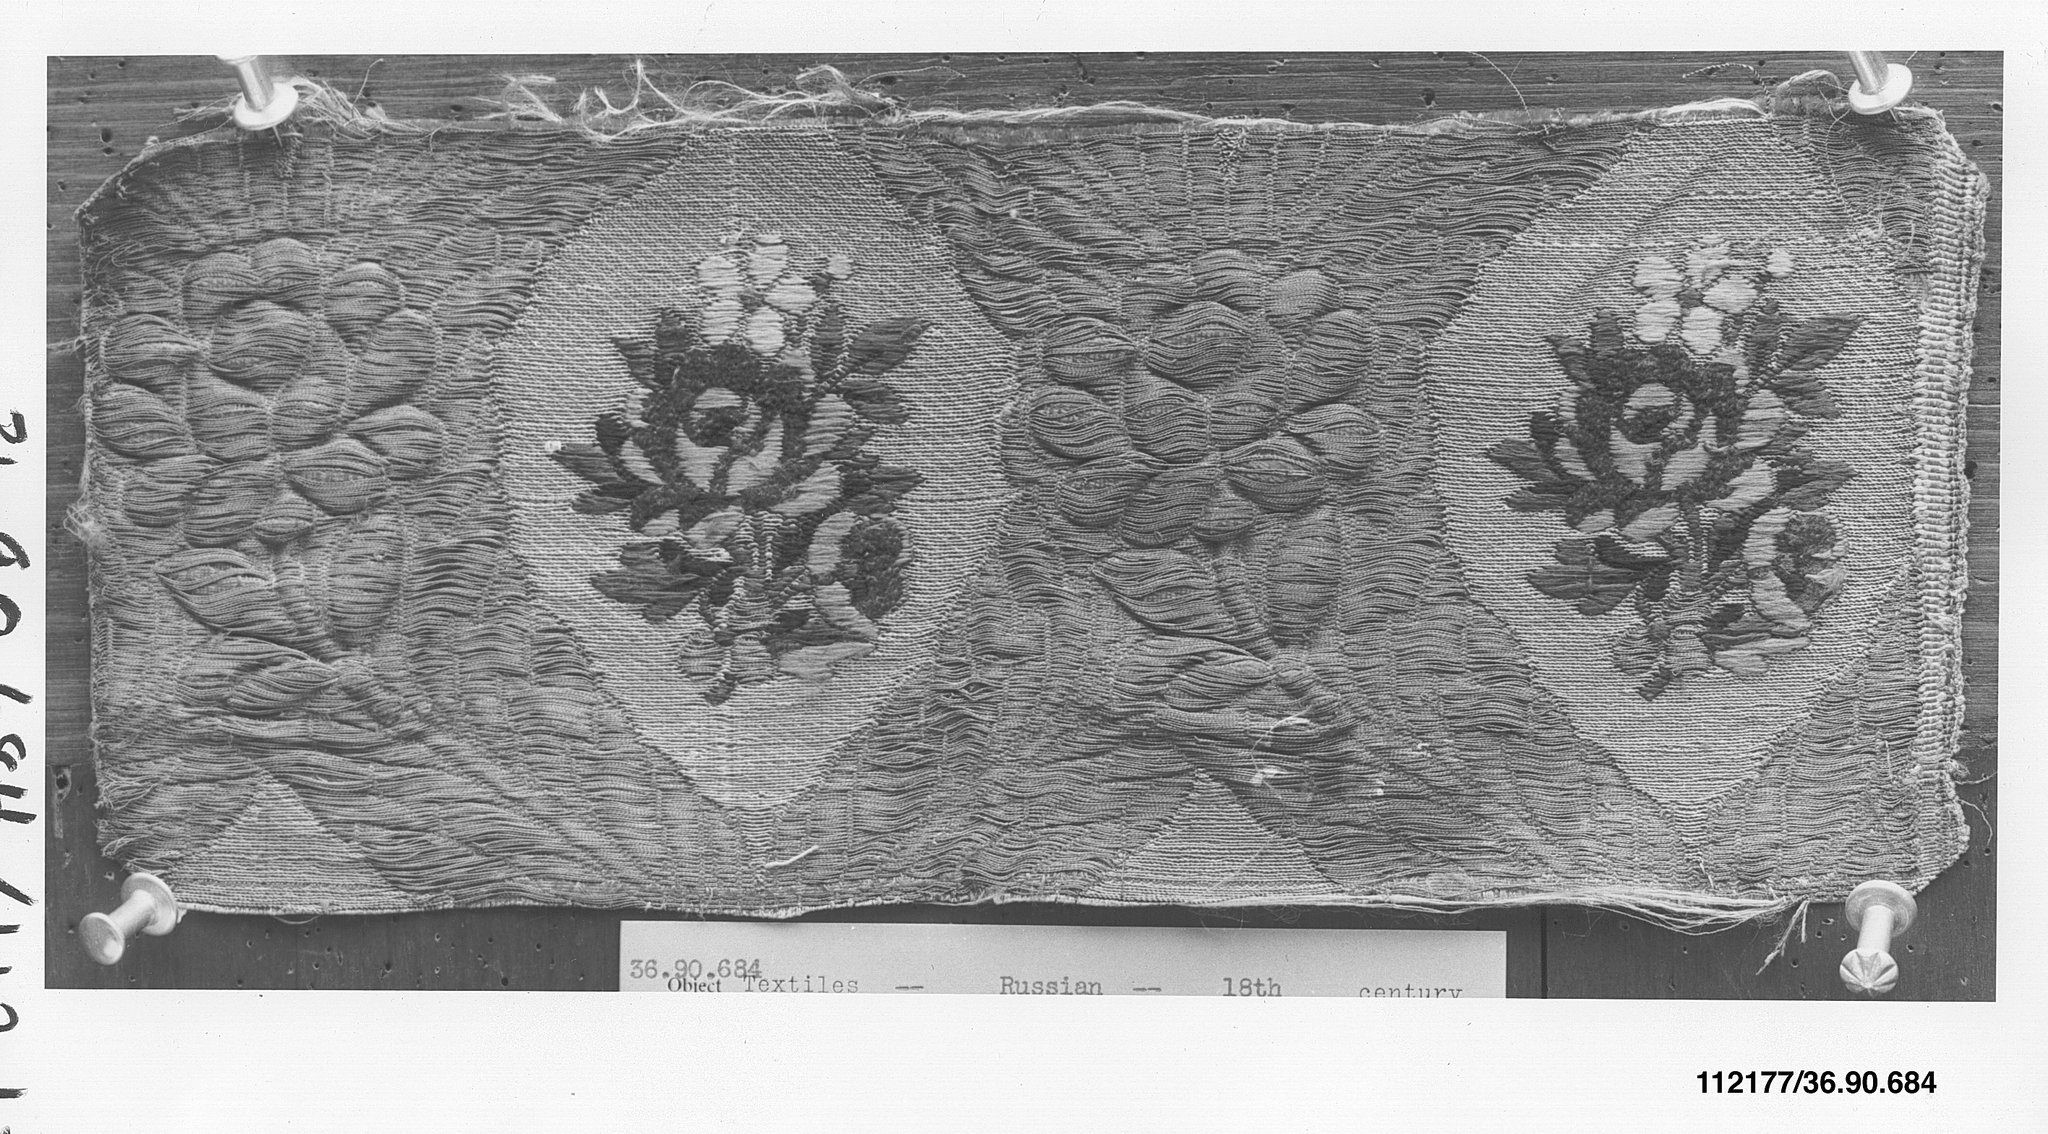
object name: piece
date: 1701-1800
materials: metal thread, silk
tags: flowers,leaves